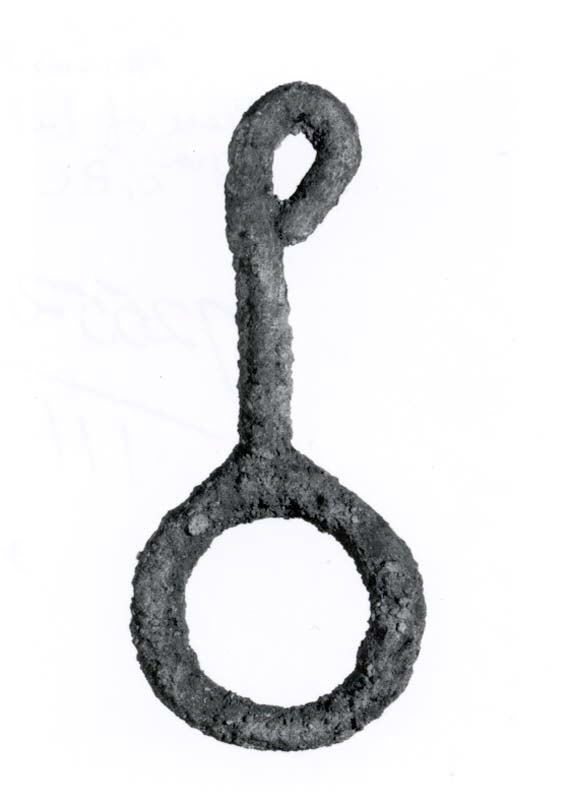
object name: horse bit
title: Half of a horse bit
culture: iranian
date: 900-801 BCE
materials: bronze, copper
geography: iran